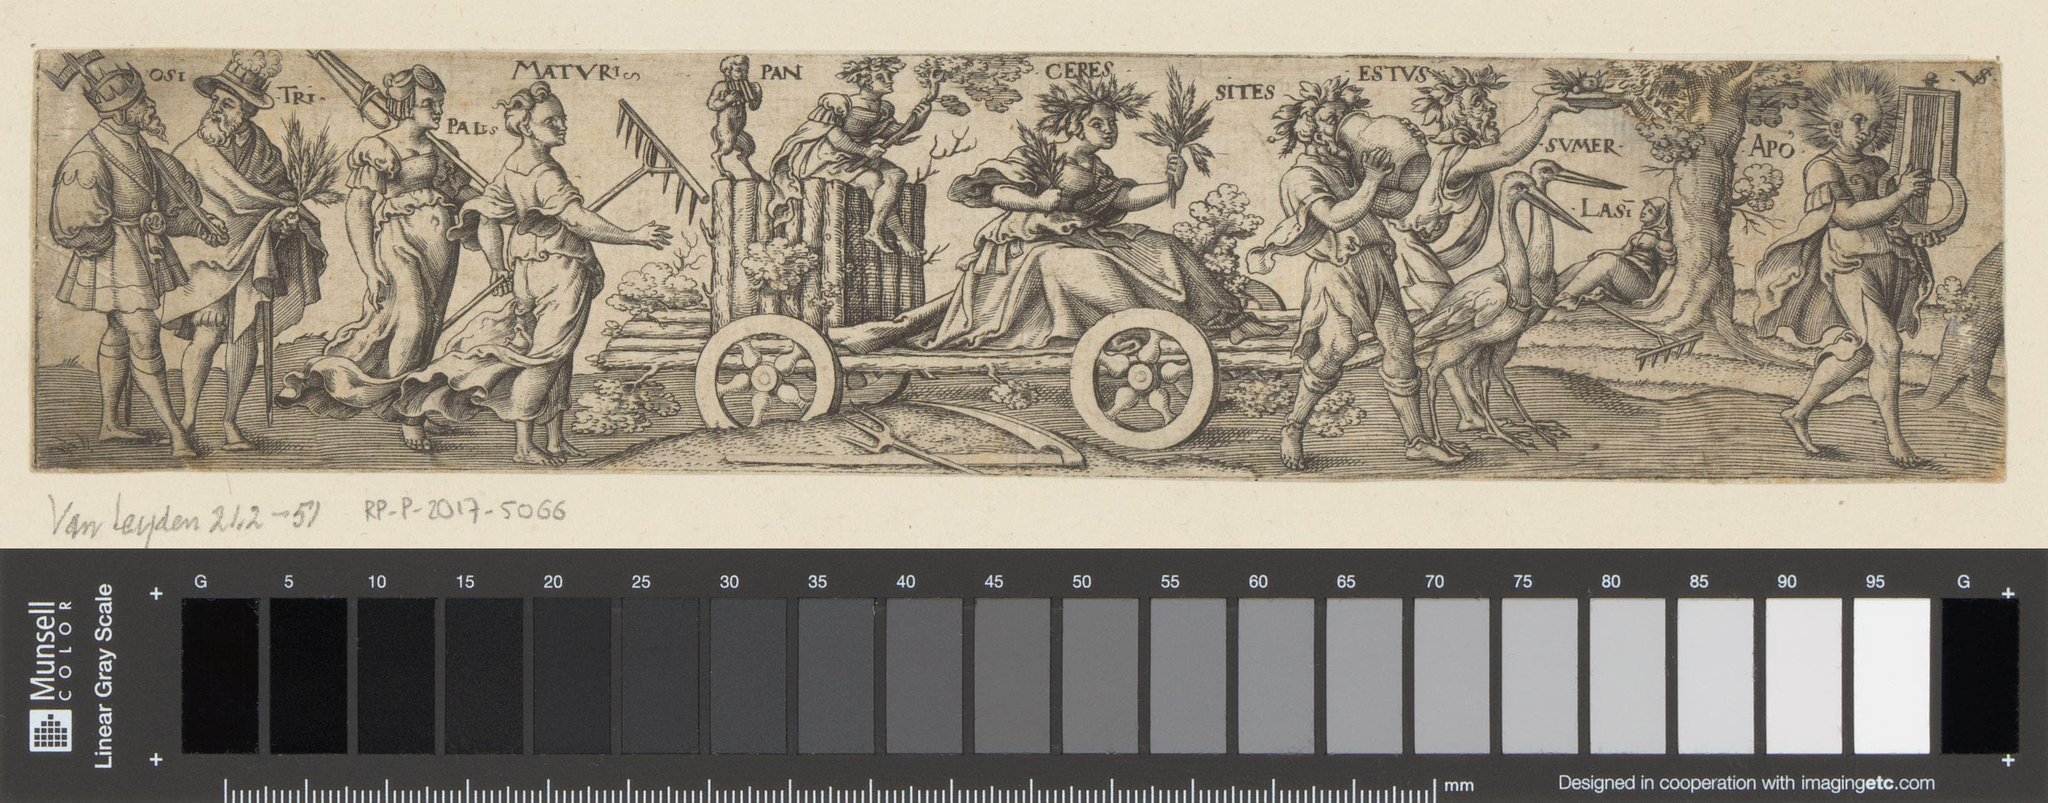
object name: print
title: Allegorieën van de seizoenen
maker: virgilius solis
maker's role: draughtsman, print maker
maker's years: 1514-1562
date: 1524-1562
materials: paper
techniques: engraving, etching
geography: nuremberg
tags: (story of) ceres (demeter), panpipes, chariot, triumphal car, summer ~ human activities (the four seasons of the year)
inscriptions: number: ‘21,2. [...] - 51’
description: Maakt deel uit van een reeks van vier prenten met voostellingen van triomftochten met mythologische figuren als allegorieën van de seizoenen.